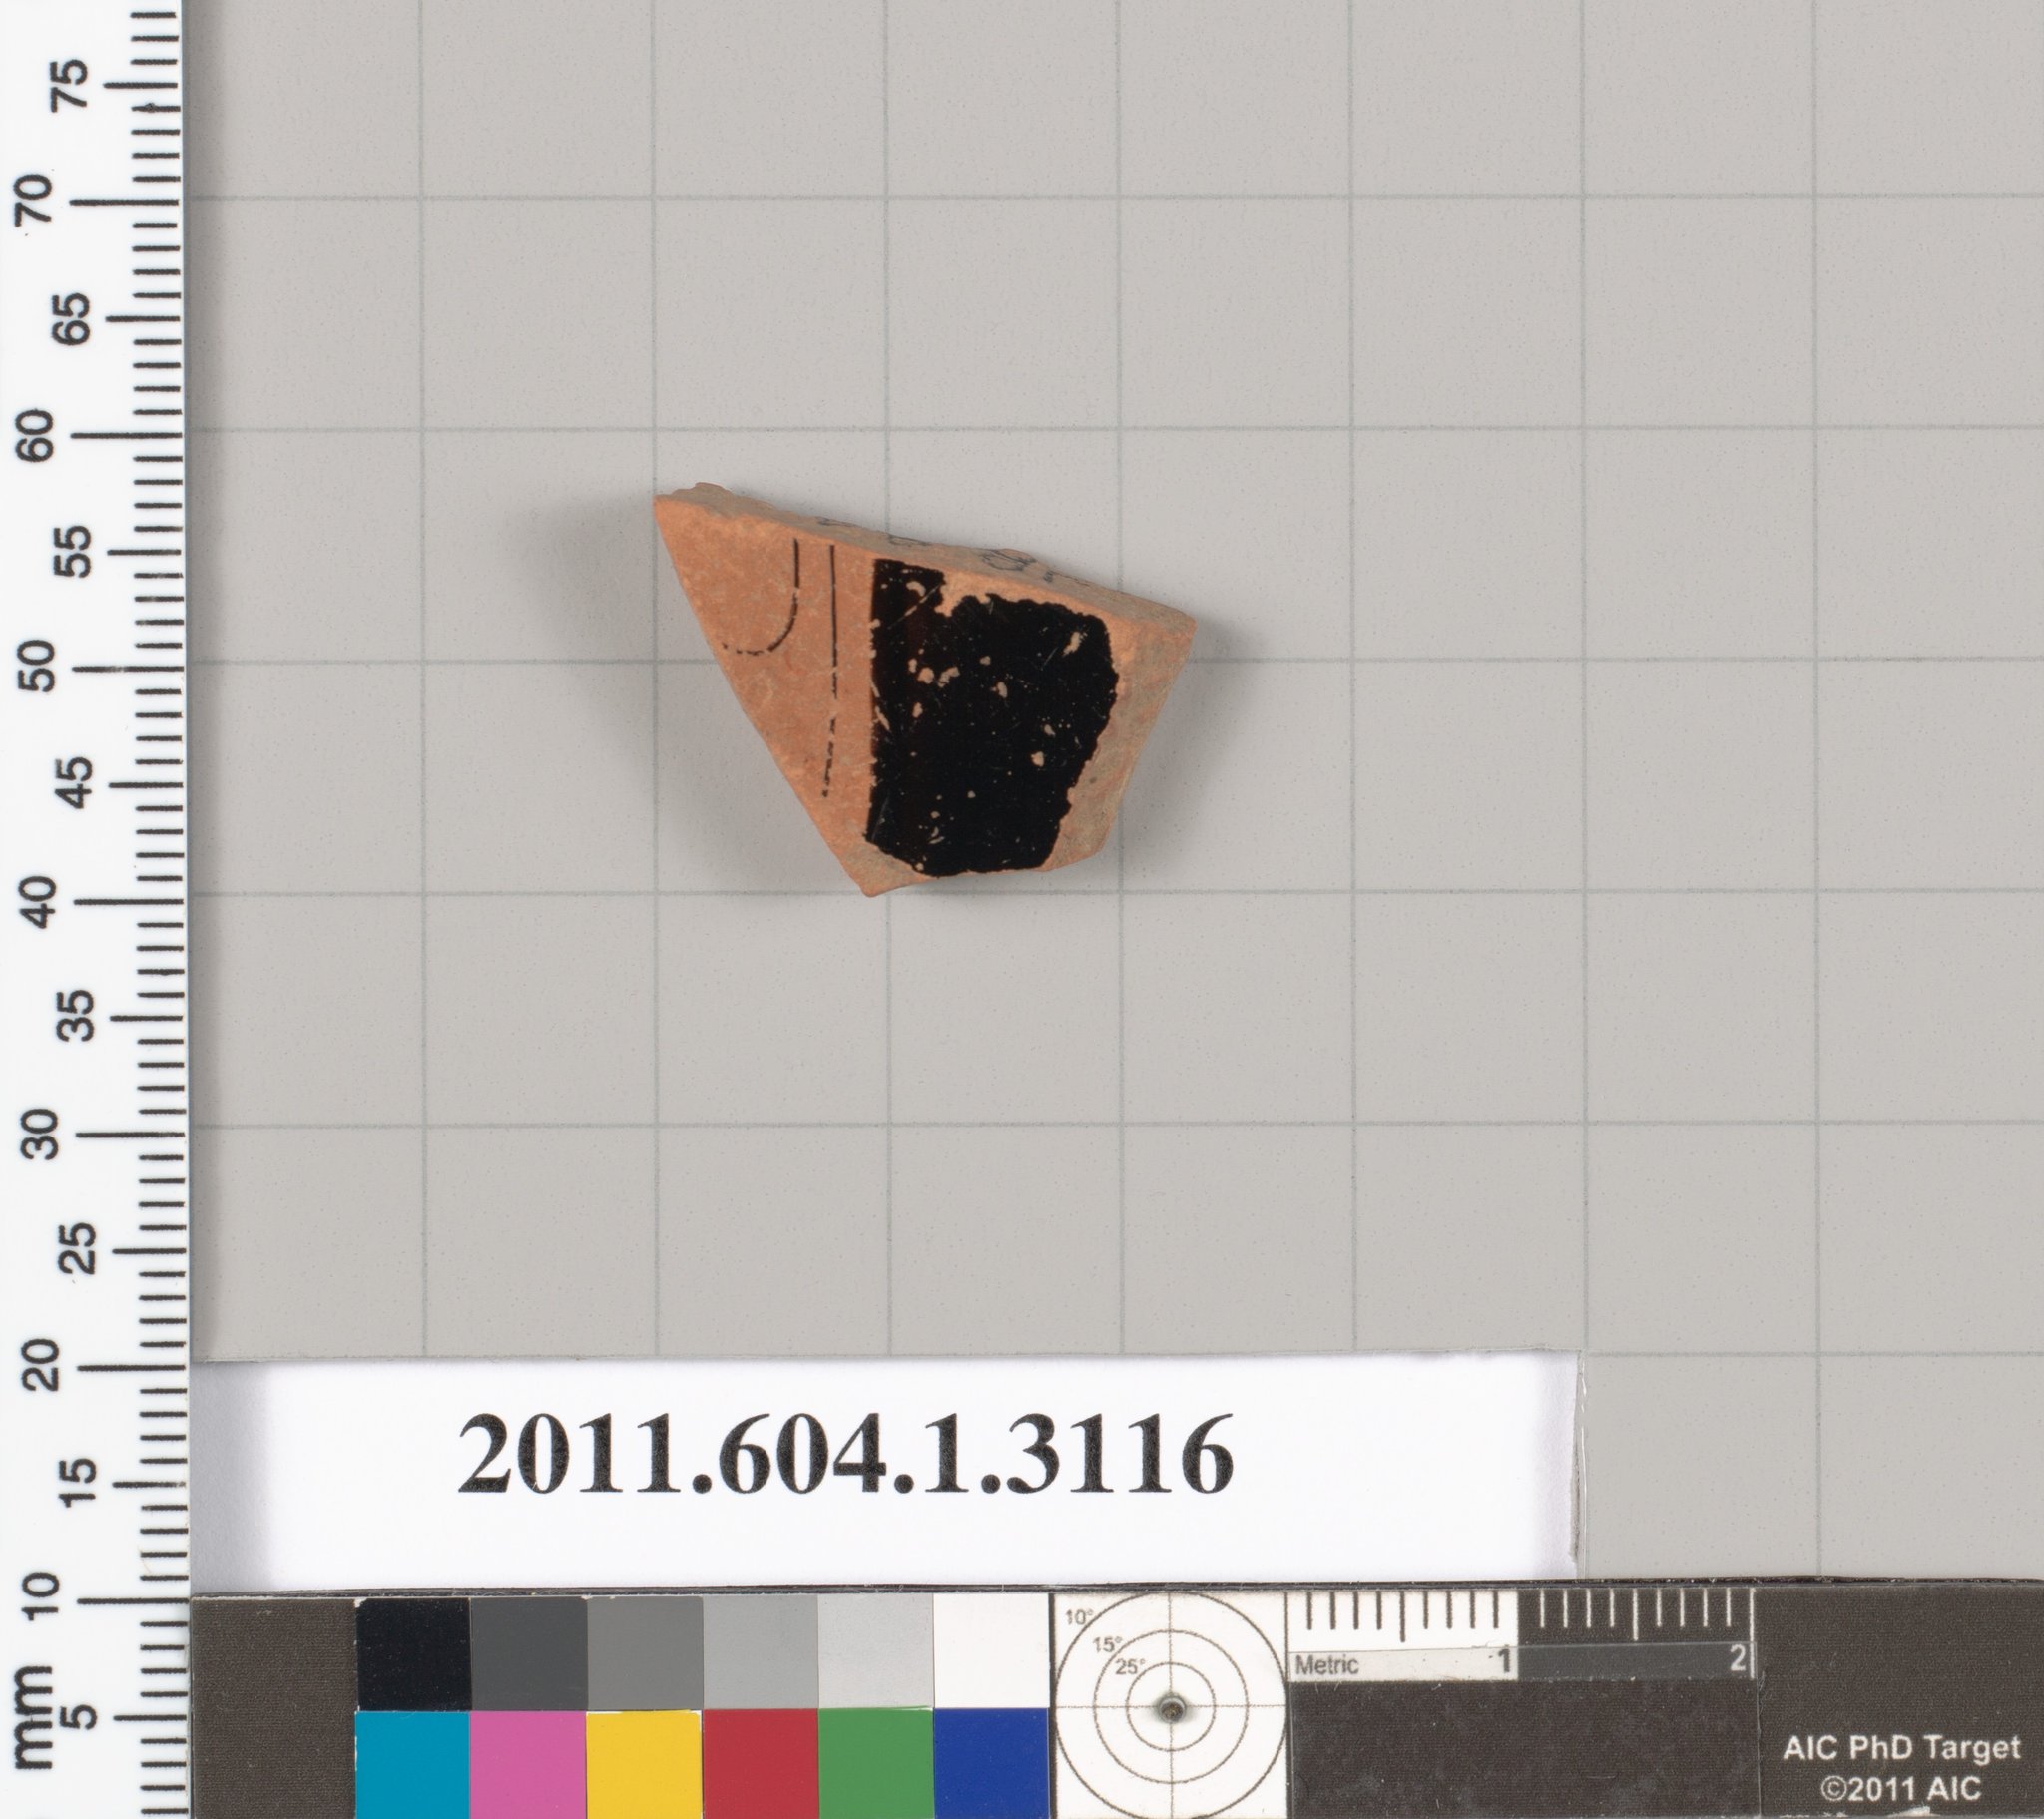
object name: kylix fragment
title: Terracotta fragment of a kylix (drinking cup)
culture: greek, attic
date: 475-451 BCE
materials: terracotta